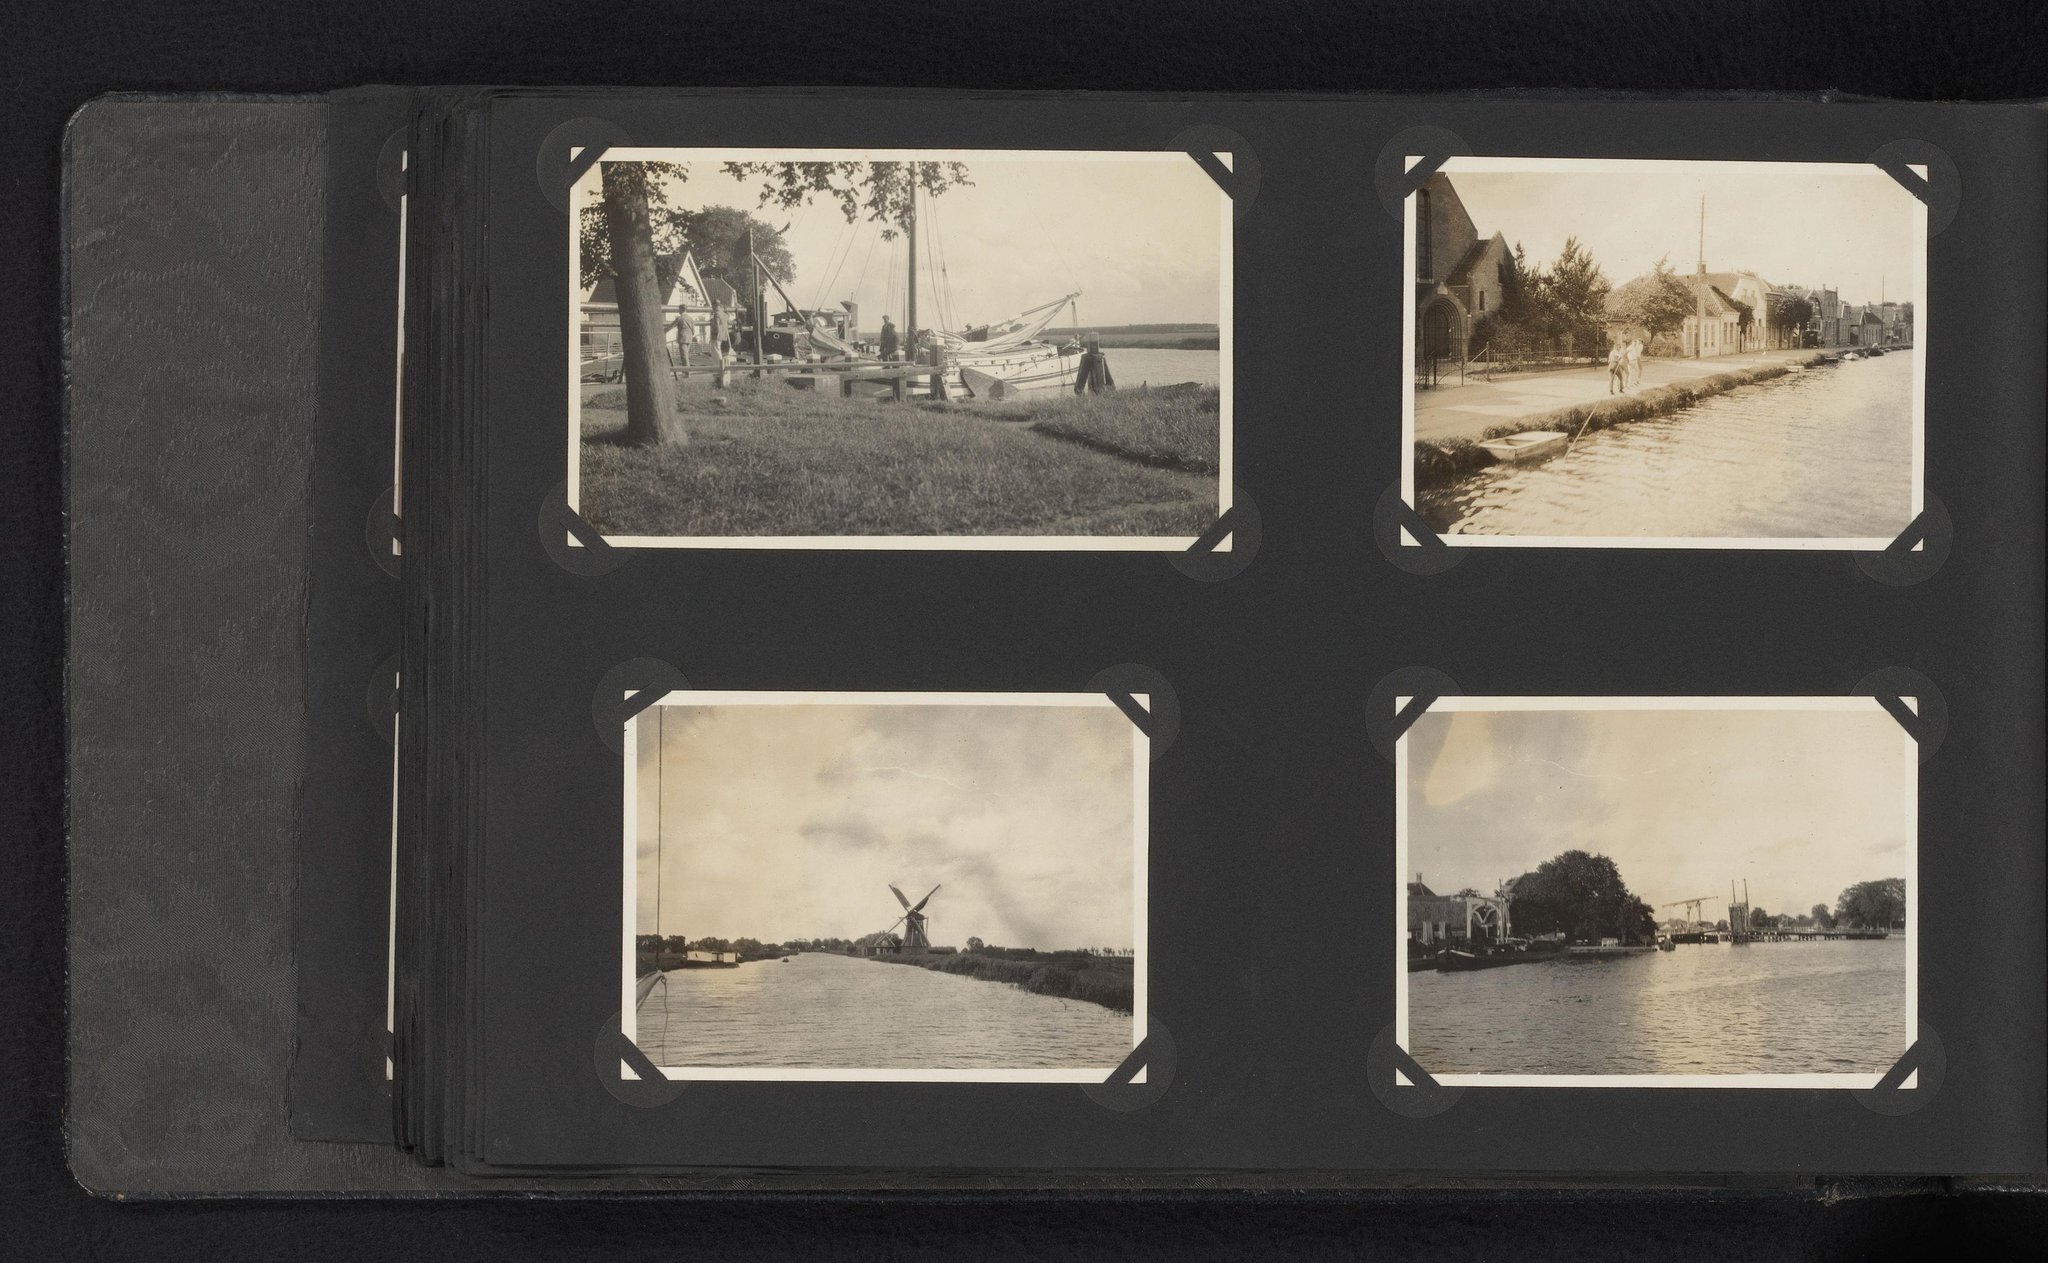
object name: photograph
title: Vier foto's van zeilboot De Snits en rivieren in Nederland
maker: hendrik herman van den berg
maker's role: amateurfotograaf, jurist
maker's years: 1875-1944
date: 1926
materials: paper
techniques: gelatin silver print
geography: netherlands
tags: sailing-ship, sailing-boat, river, windmill in landscape, netherlands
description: Deze foto's maken deel uit van een album.